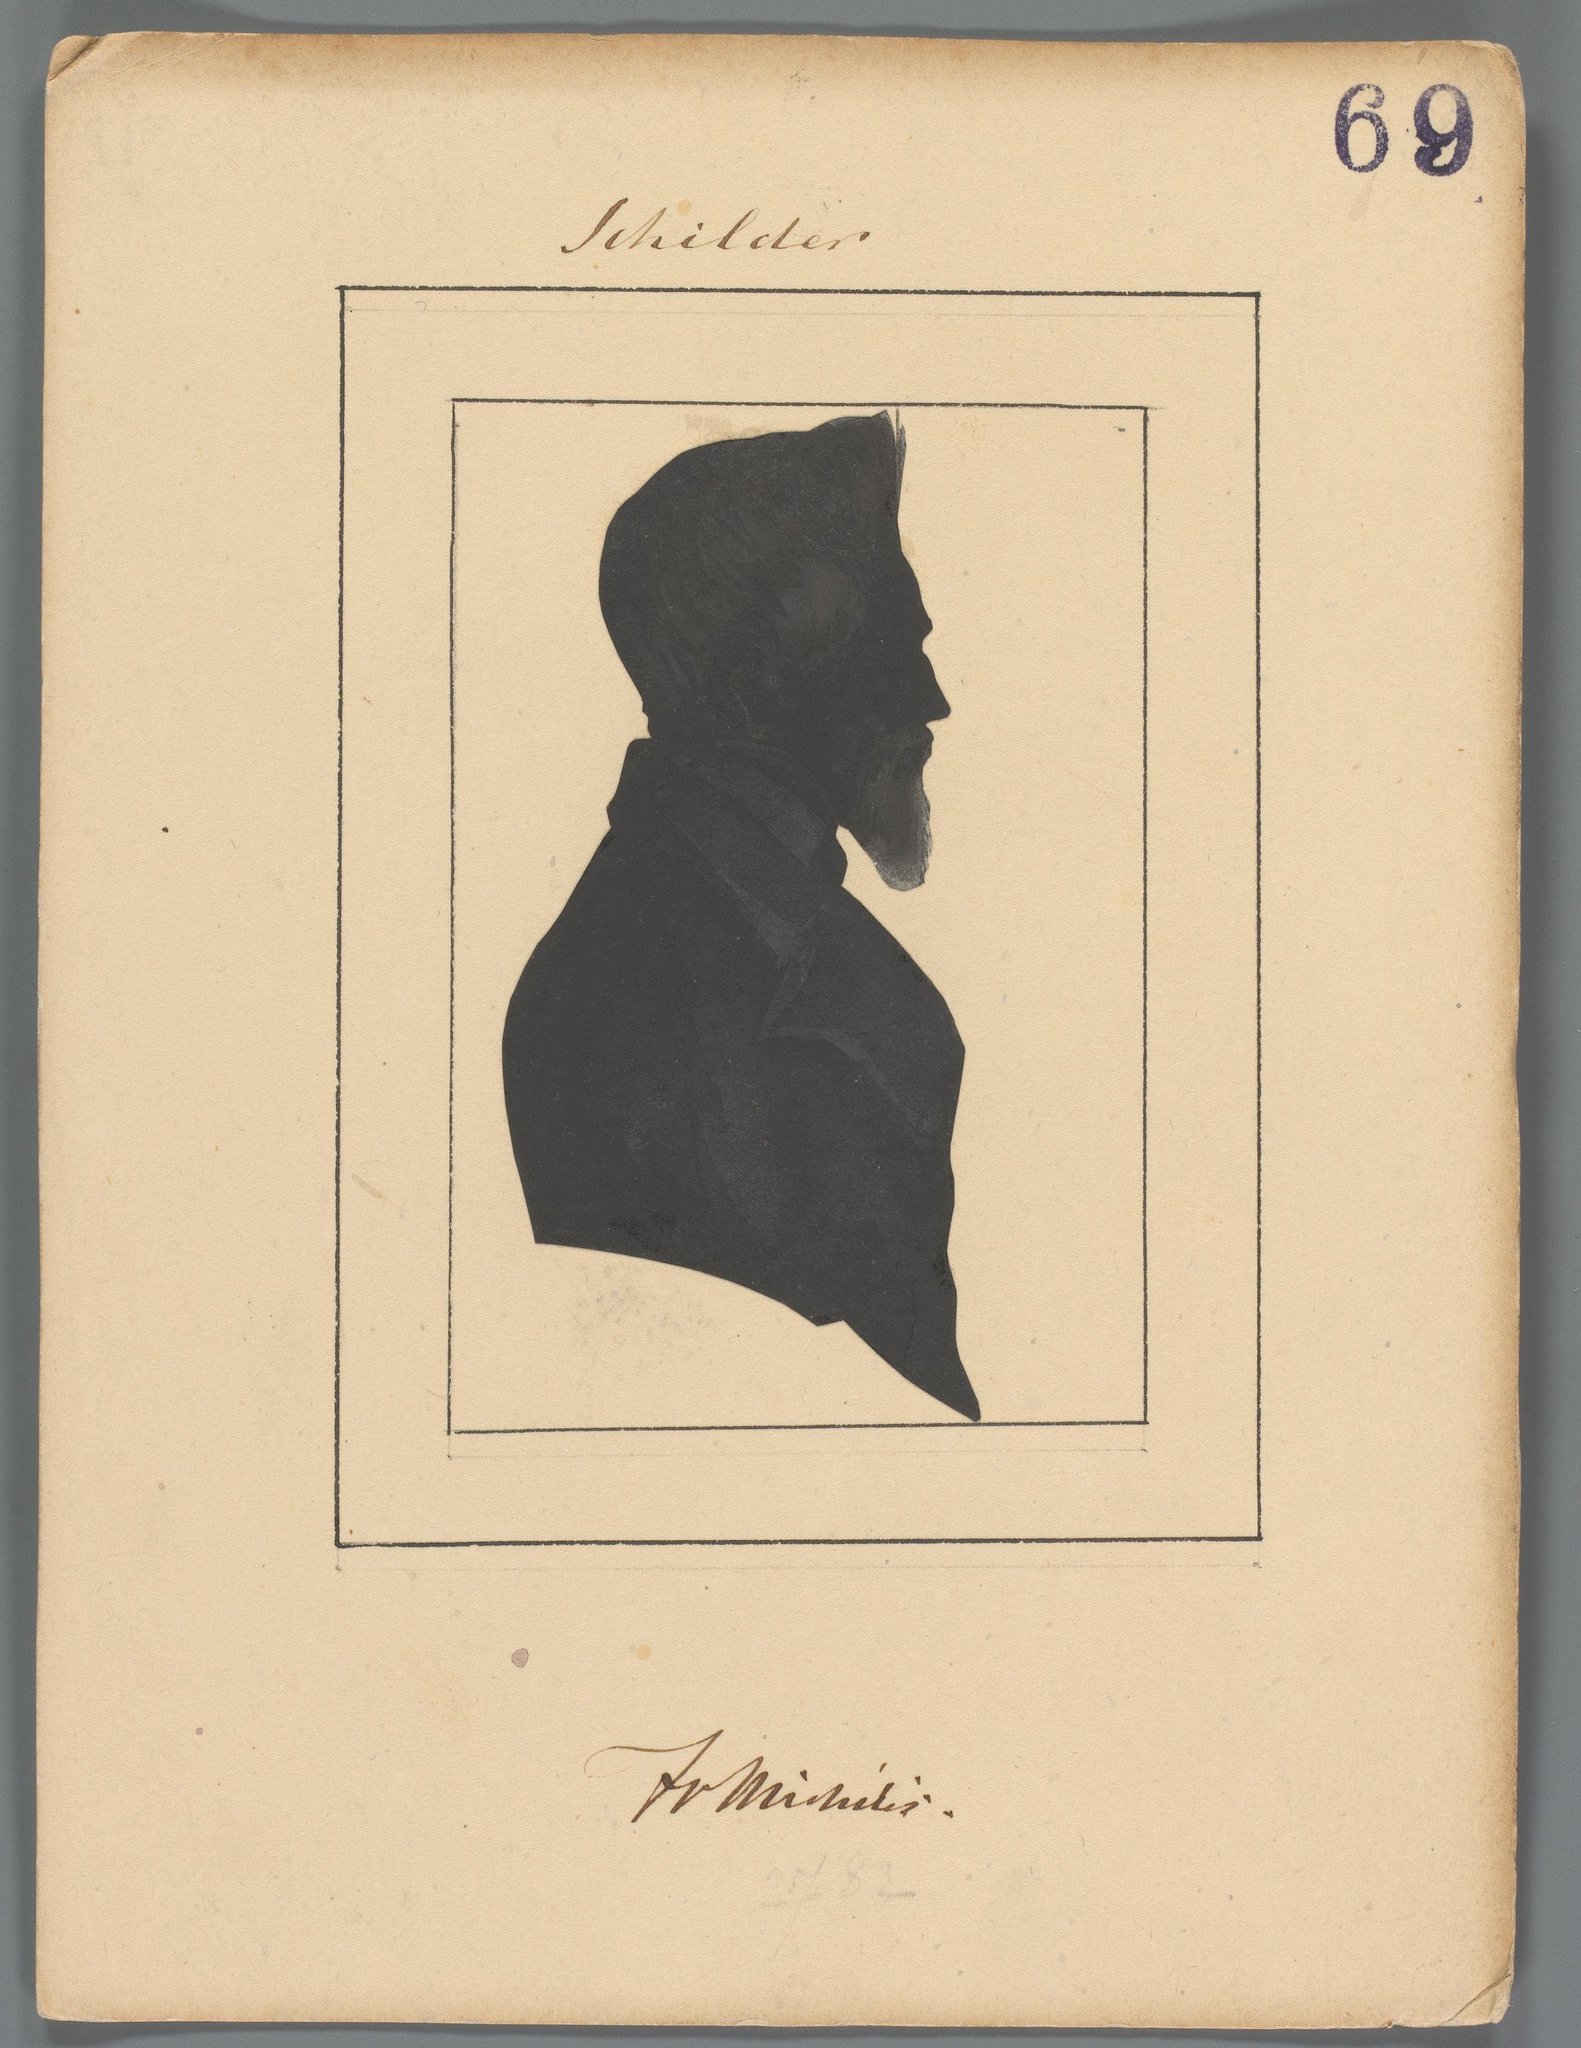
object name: cut paper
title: Silhouetportret van Franz Michelis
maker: elisabeth alida haanen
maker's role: draughtsman, print maker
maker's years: 1809-1845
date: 1819-1845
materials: ink, paint, paper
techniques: brush, snipping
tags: franz michelis (i), historical persons, portrait, self-portrait of painter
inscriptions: inscription: ‘Schilder’, inscription: ‘FrMichelis’, inscription: ‘Neg. D. 1785’, number: ‘69’, collector's mark: ‘Ex-libris van Beresteyn’, number: ‘14012’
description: Met onder het portret de handtekening van de geportretteerde.